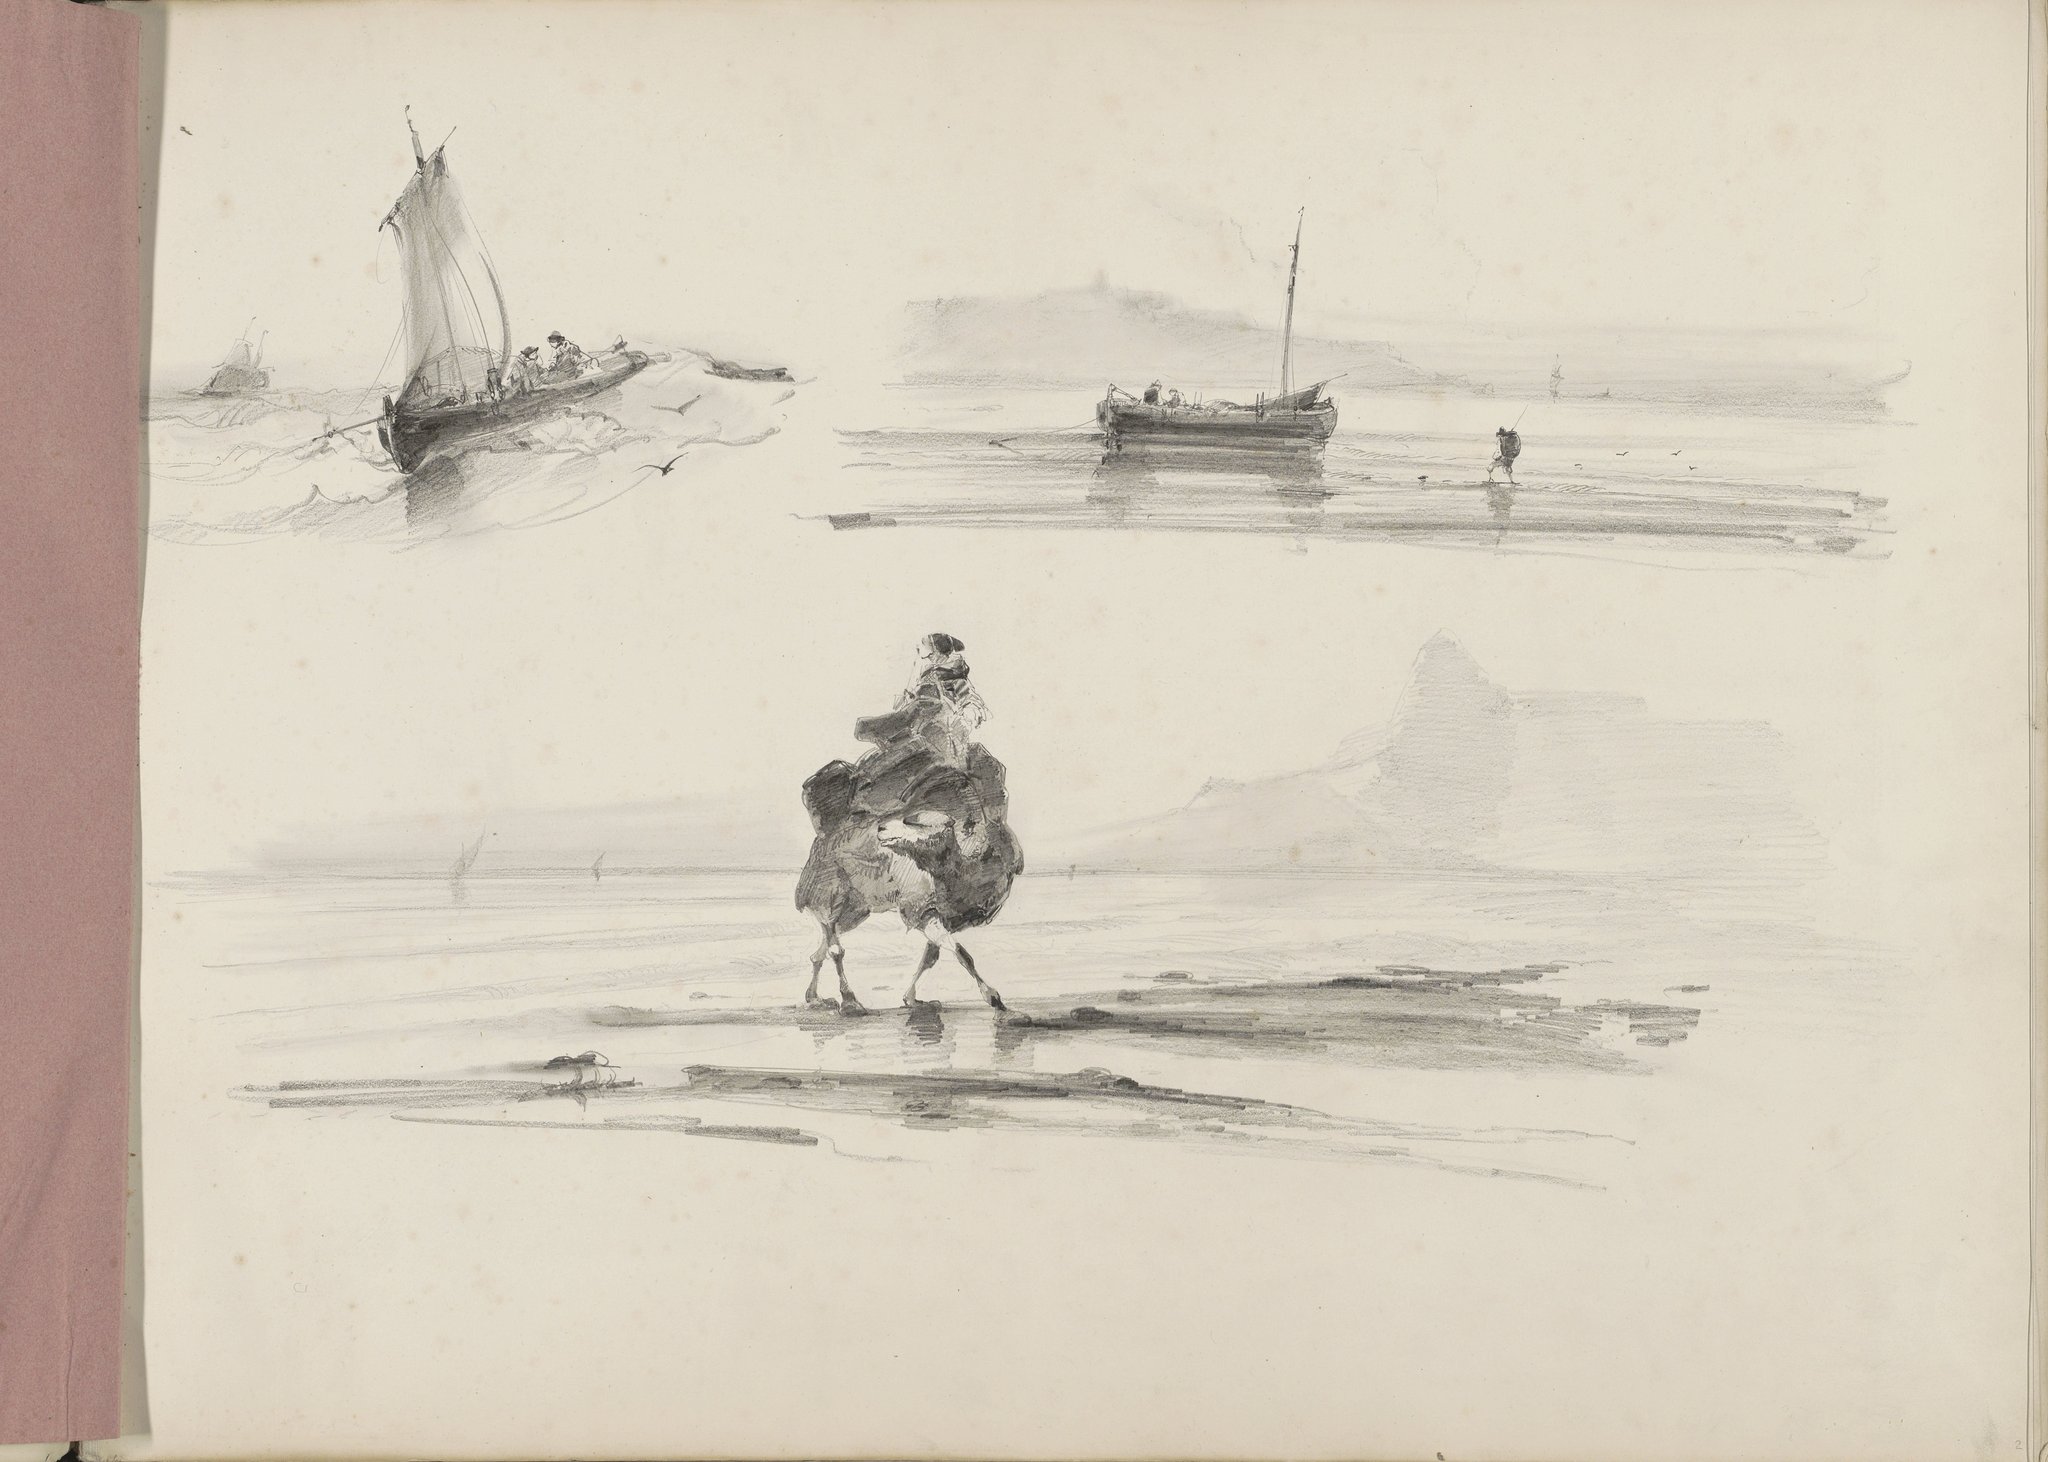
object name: sketchbook leaf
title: Zeegezichten met zeilboten en een man op een kameel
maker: albertus van beest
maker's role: draughtsman, print maker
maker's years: 1820-1860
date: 1830-1860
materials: paper, pencil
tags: hoofed animals: camel, sailing-ship, sailing-boat, coast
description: Zeilboot op een woelige zee en een afgemeerde zeilboot voor een kust. Tevens een studie van een man die op een kameel rijdt langs een kust met op de achtergrond de contouren van bergen. Blad 2 recto uit een schetsboek met 10 bladen.